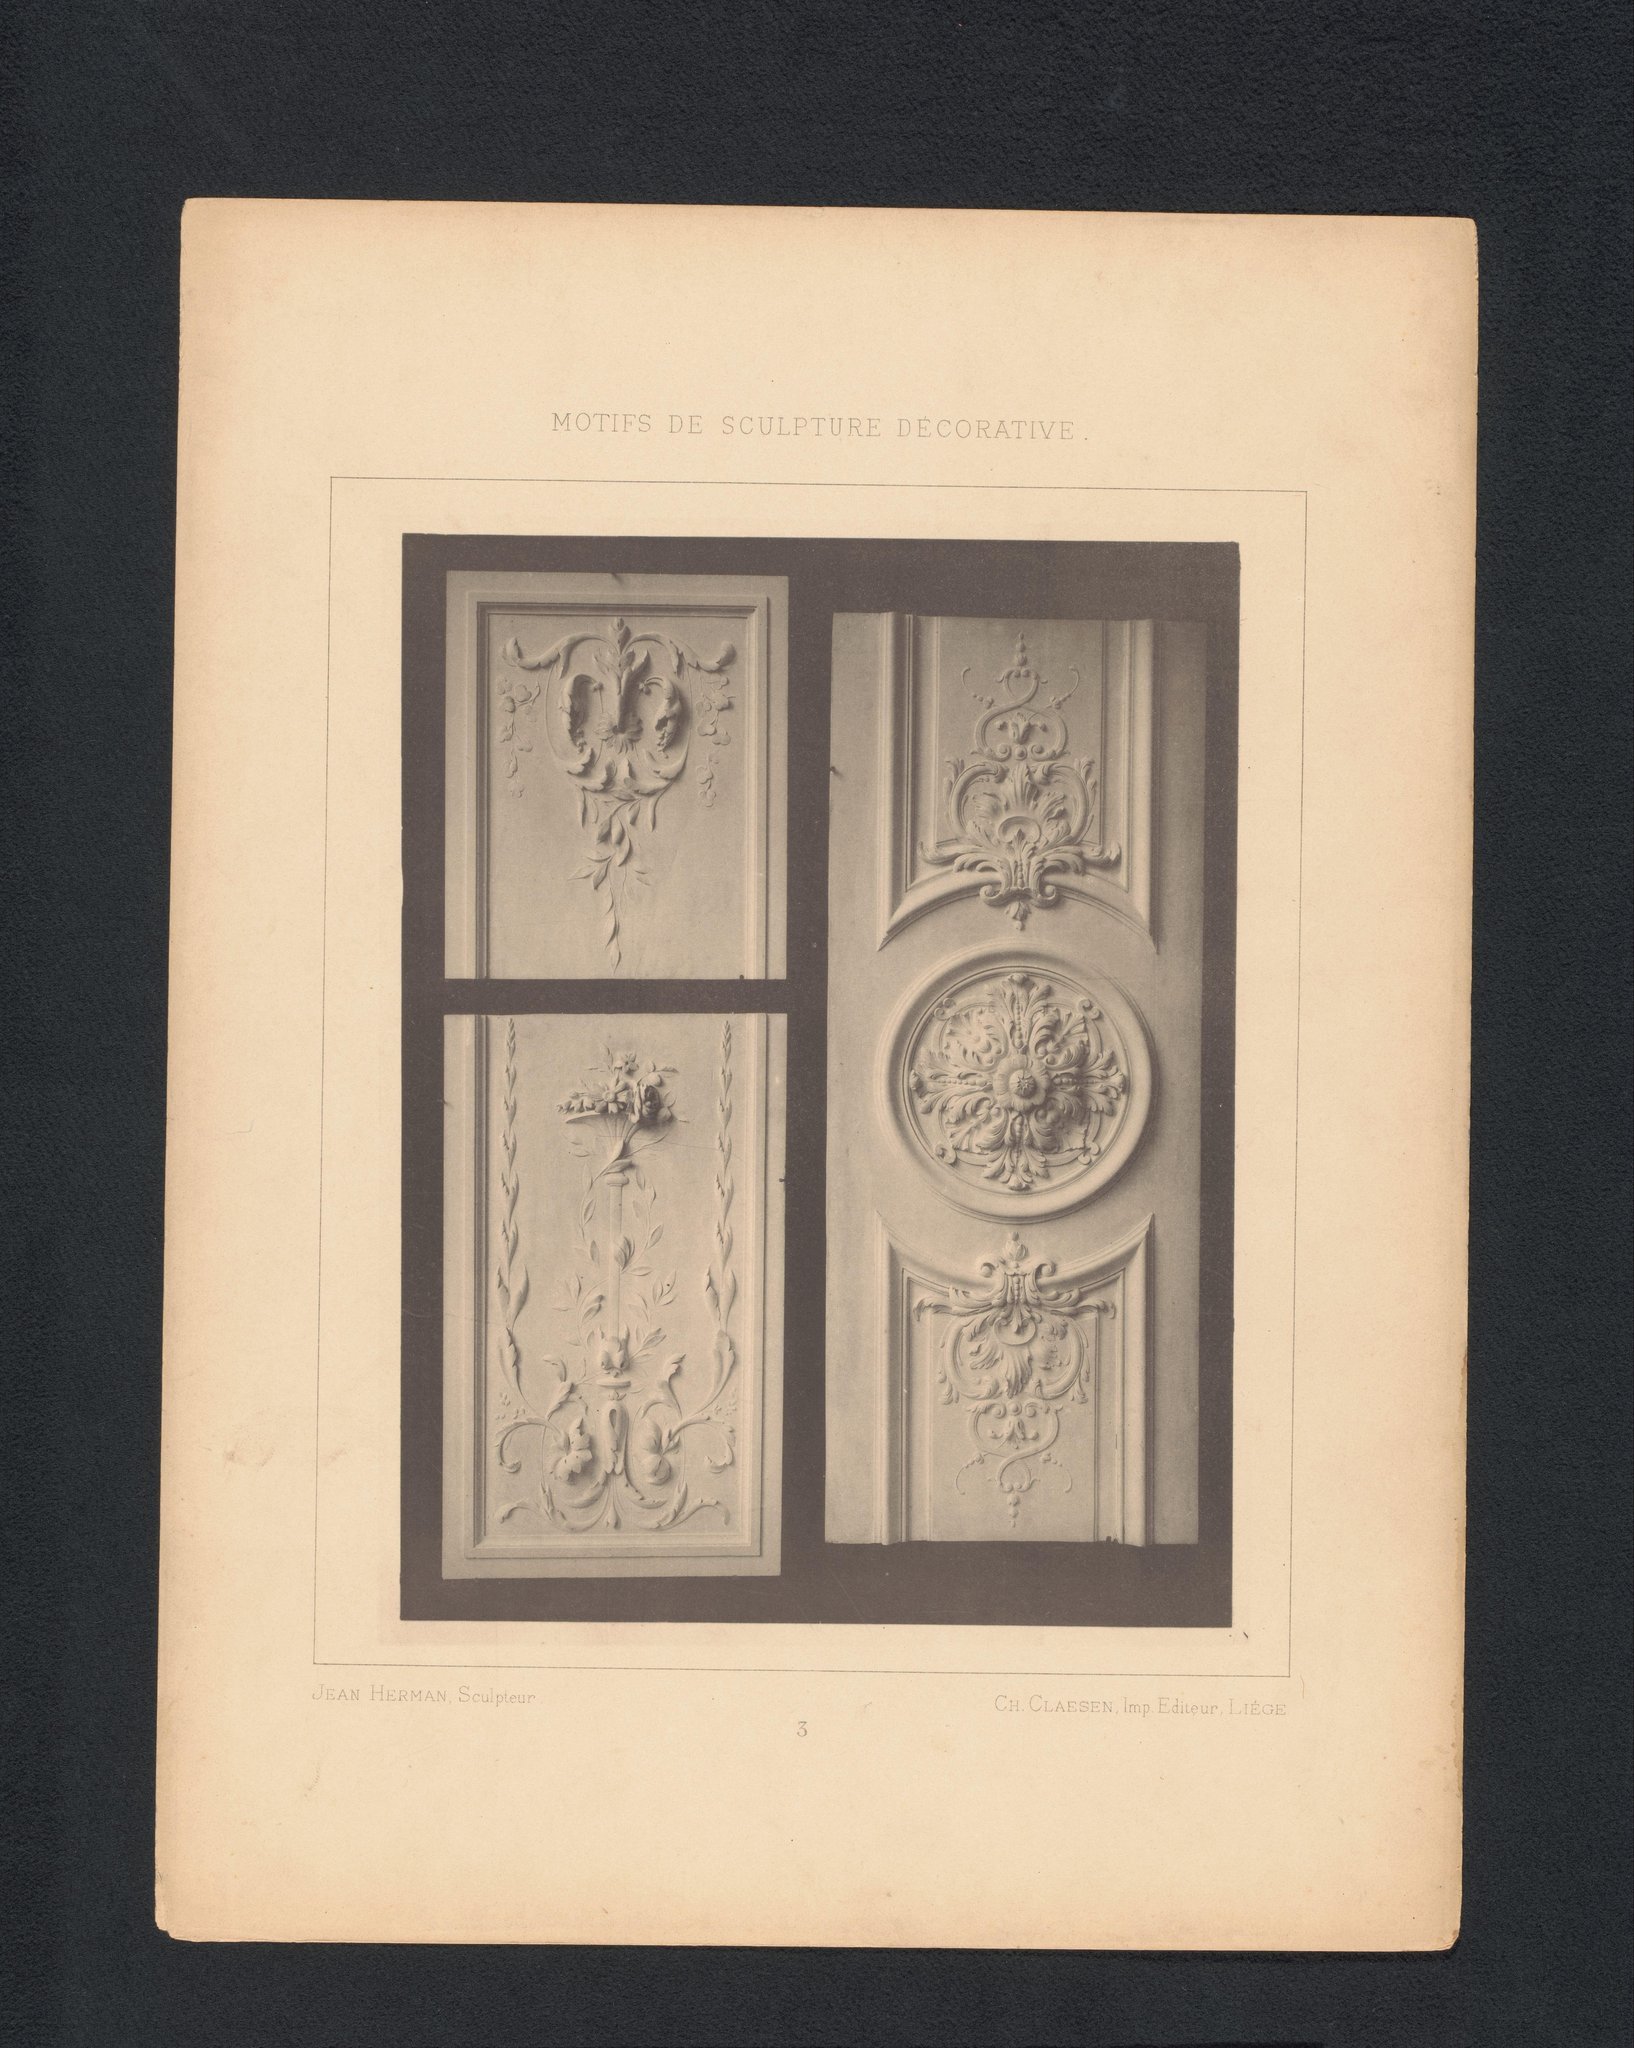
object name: photomechanical print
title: Motifs de sculpture décorative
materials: paper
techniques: photograph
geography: liège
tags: ornament derived from plant forms, sculpture (+ relief ~ sculpture)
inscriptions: inscription: ‘Jean Herman, Sculpteur.’, number: ‘3’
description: Deze prent maakt deel uit van een omslag met 28 prenten en een titelblad.